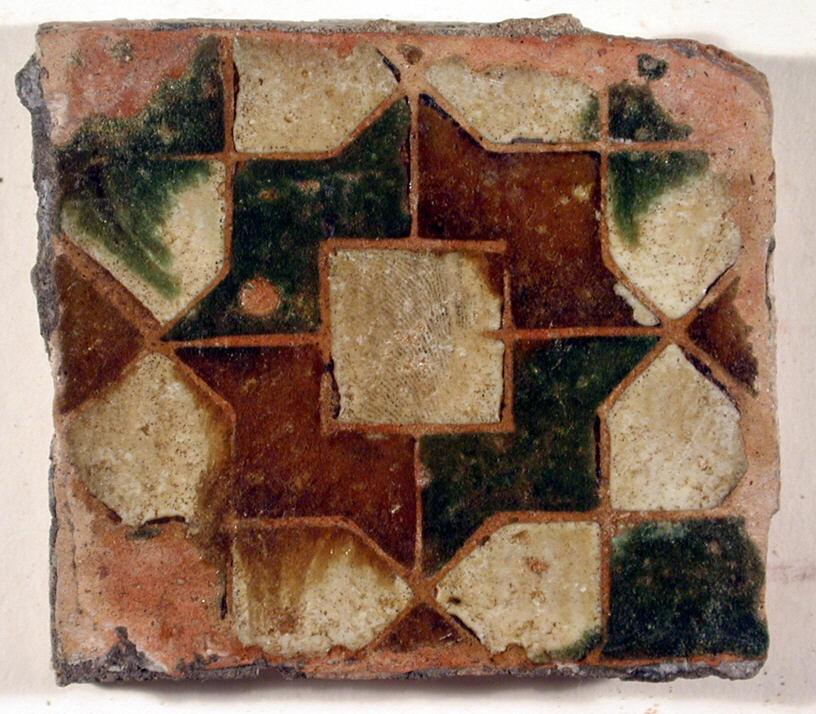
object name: tile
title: Tiles (2)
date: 1501-1700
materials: earthenware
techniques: glazing